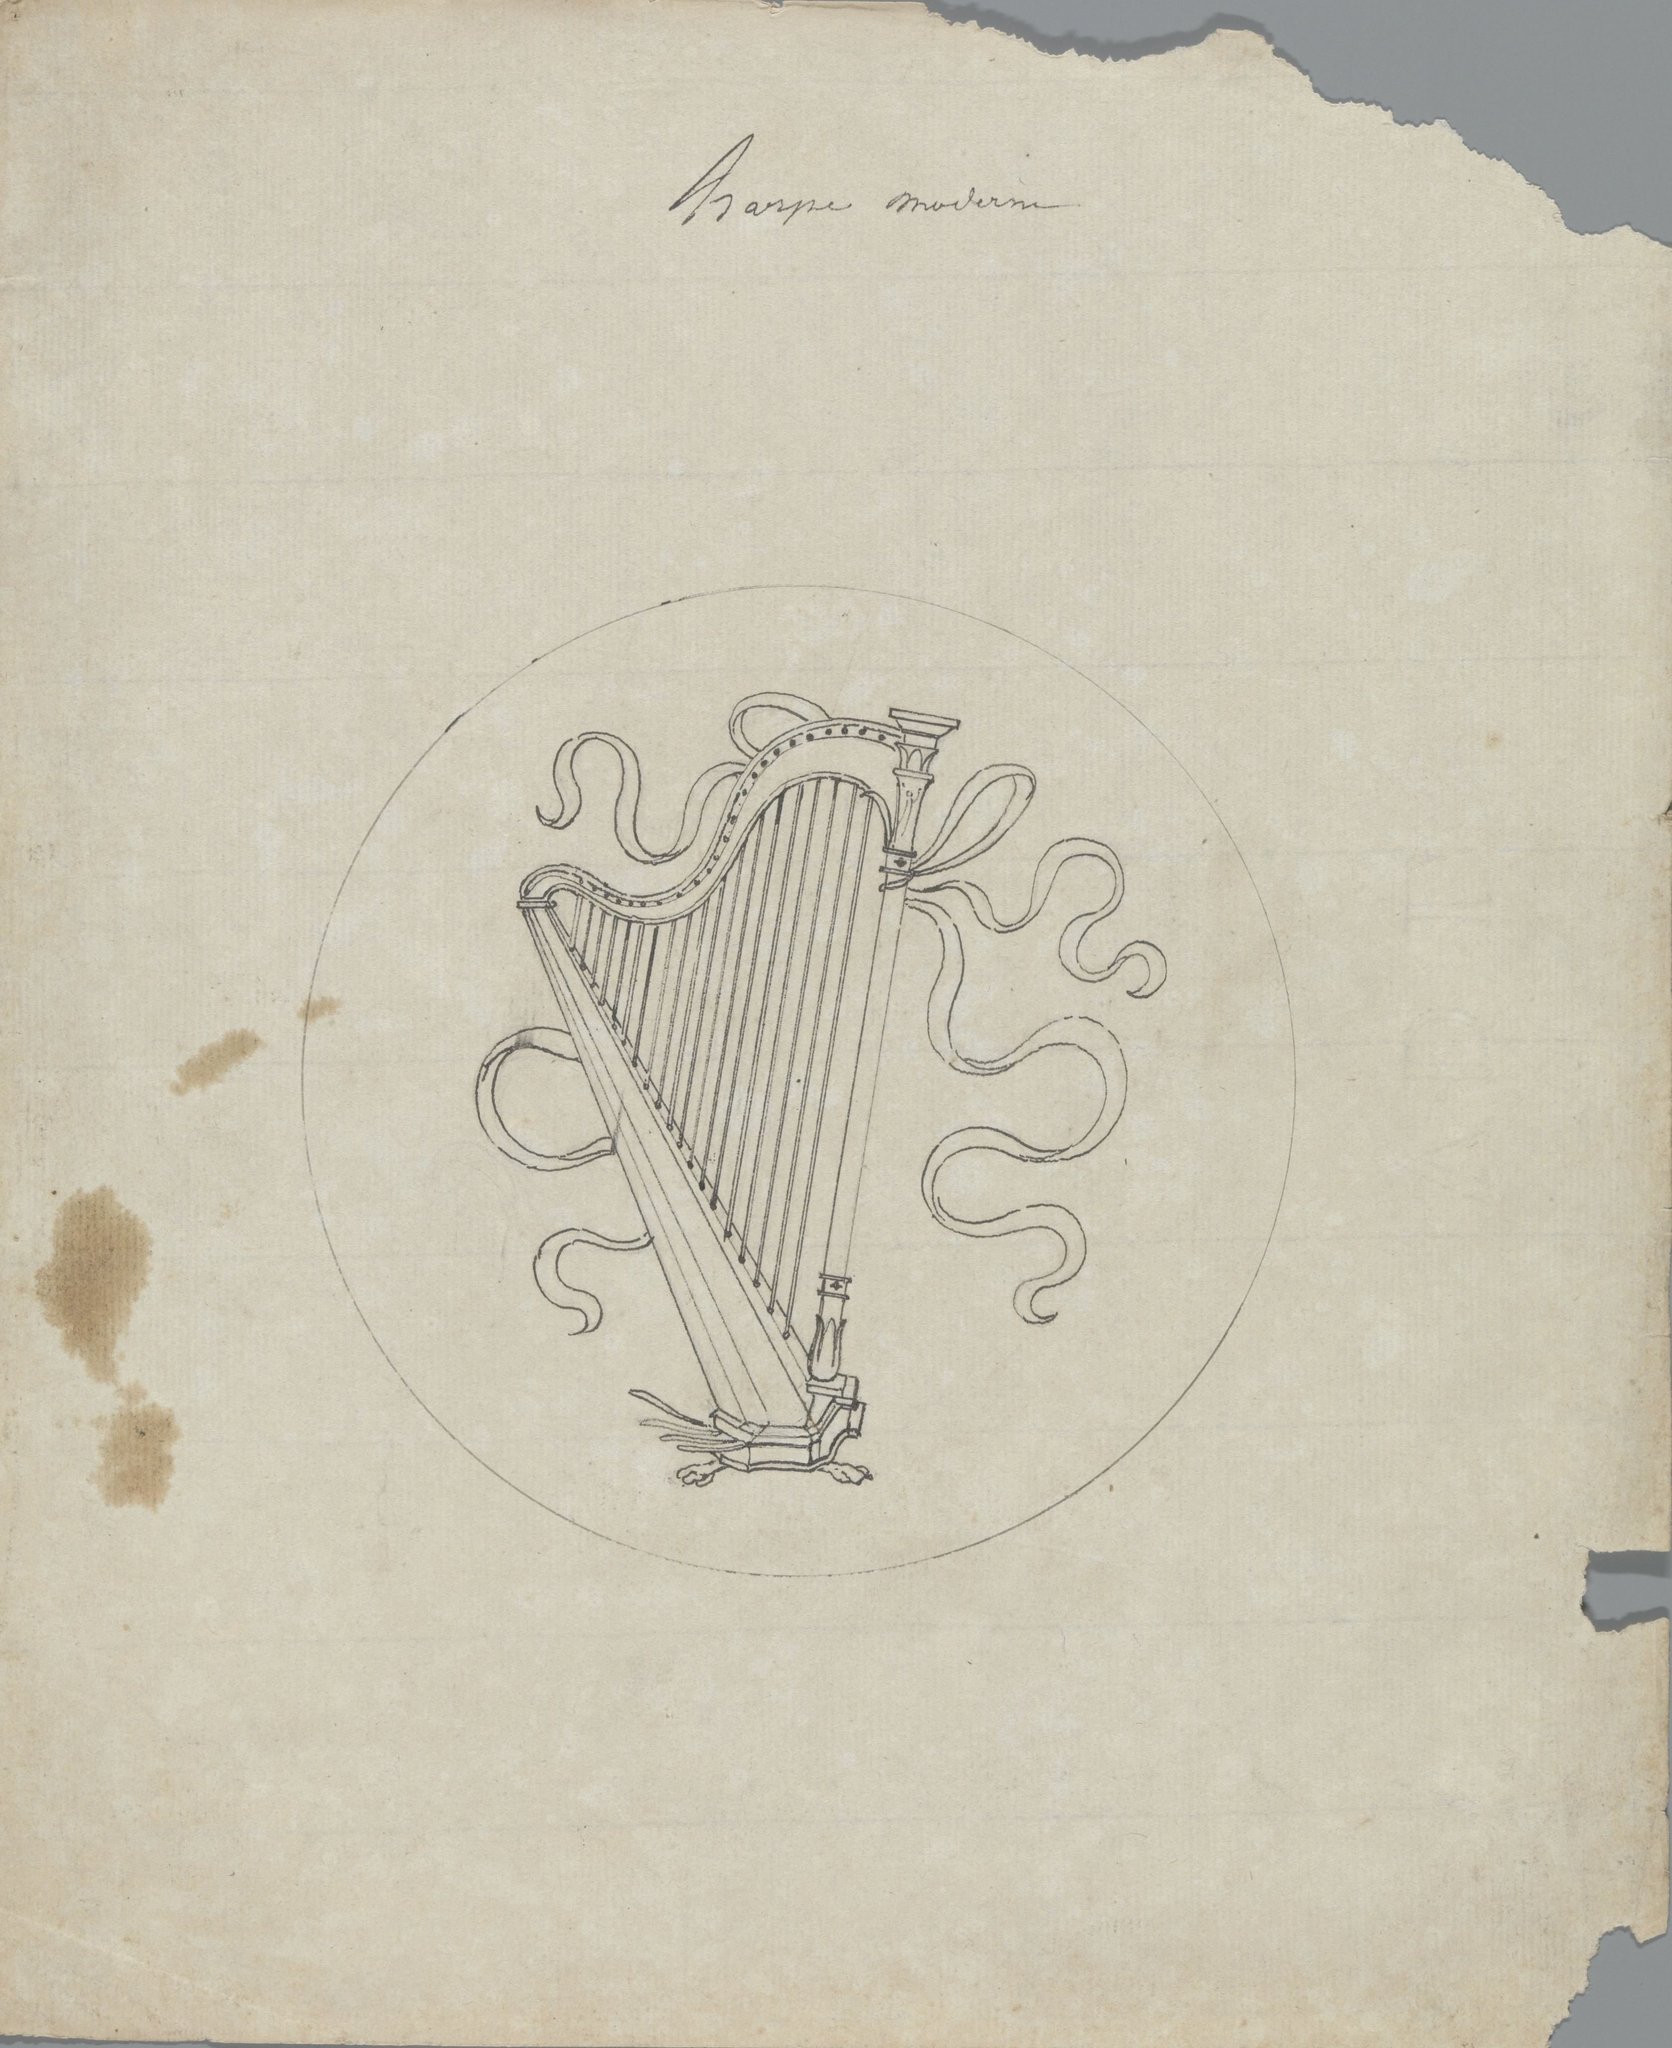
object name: design drawing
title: Ontwerp voor marqueterie van aan linten opgehangen muziekinstrument(en) in rond medaillon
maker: pierre félix van doren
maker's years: 1797-1856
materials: graphite, ink, paper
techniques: pen in black ink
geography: brussels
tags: trophy, i.e.: decorative arrangement of symbolic or typical objects ~ ornament, harp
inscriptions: inscription: ‘harpe moderne’, watermark: ‘VDL’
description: Een van 103 ontwerpen voor marqueterie van aan linten opgehangen muziekinstrumenten in ronde medaillons, bestemd voor de set stoelen gemaakt door Van Doren voor de grote zaal van het Paleis van de Prins van Oranje in Brussel in 1828.